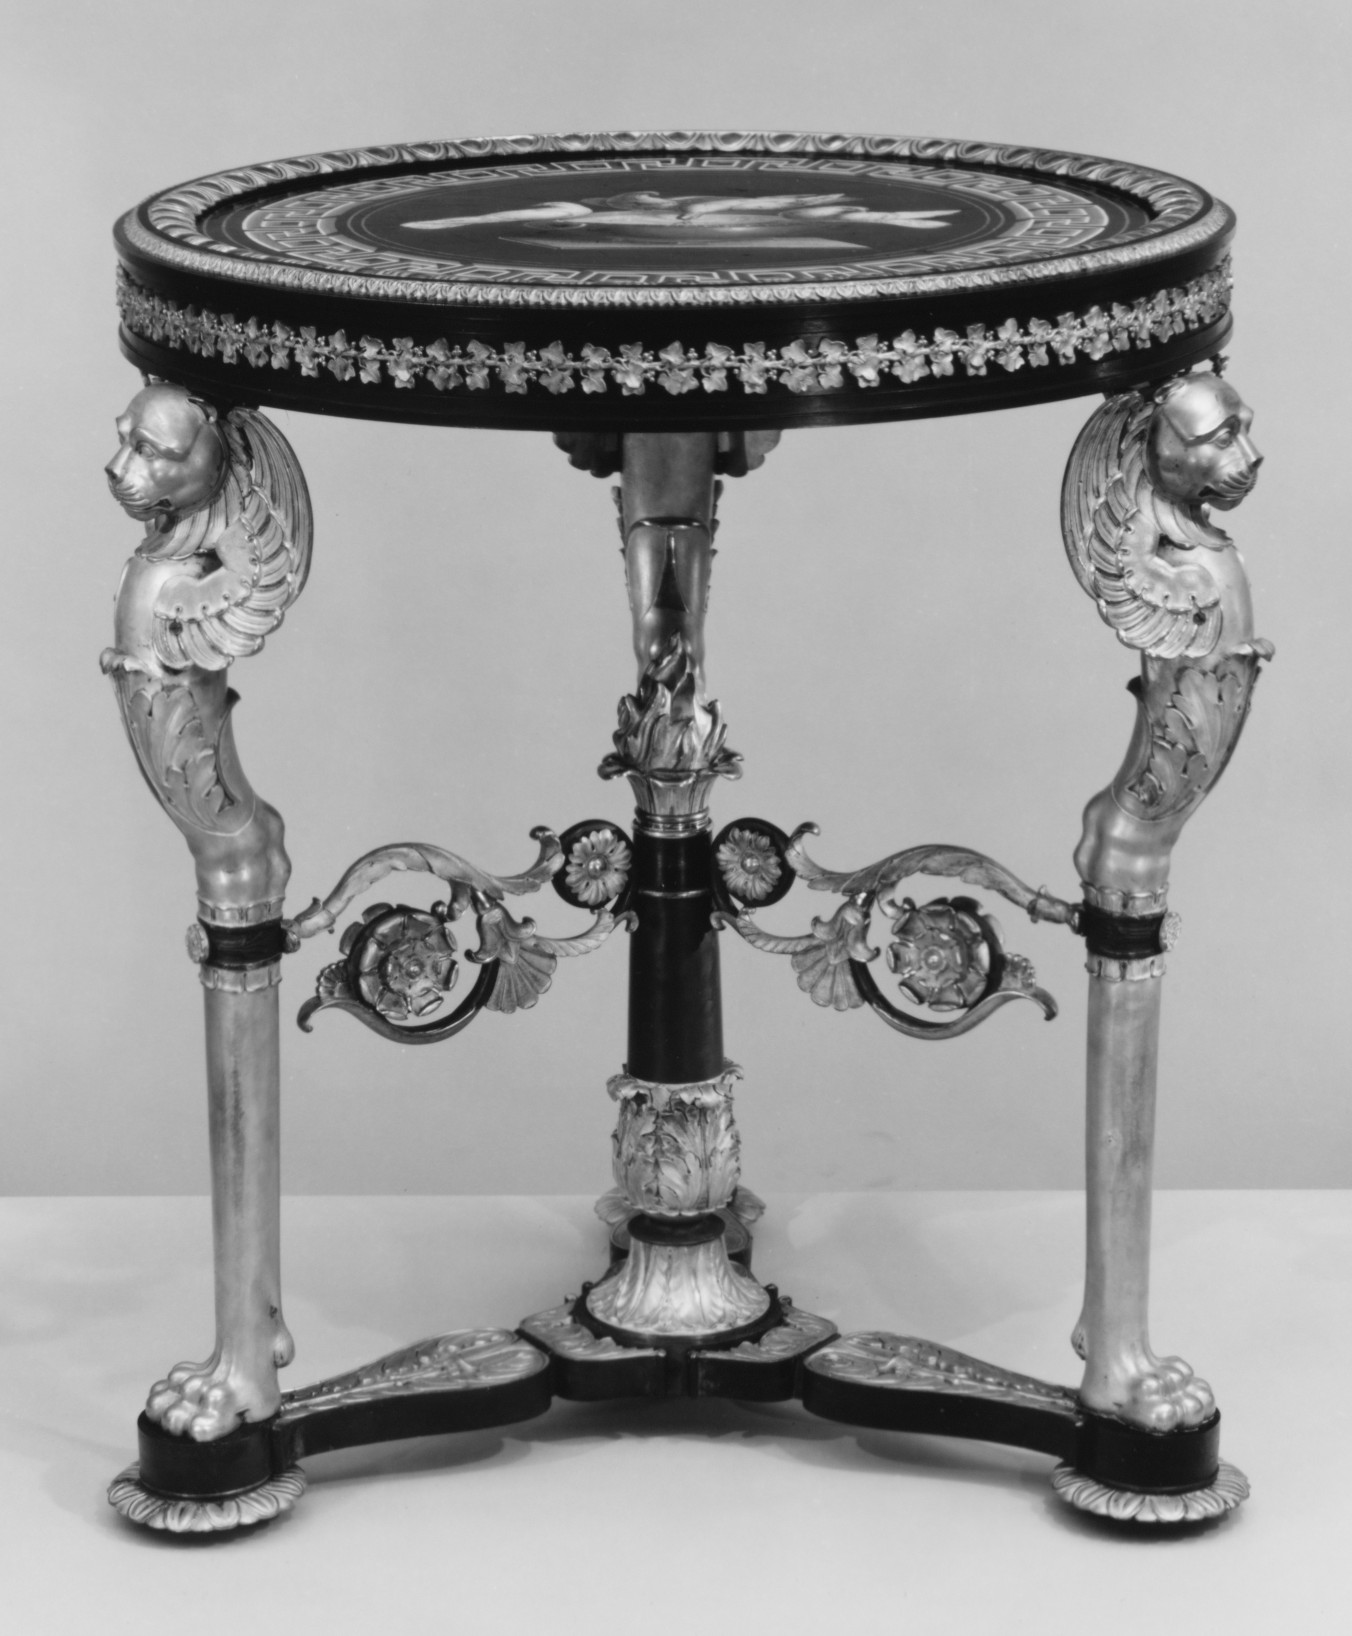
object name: tripod table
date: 1815-1825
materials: gilt bronze, wood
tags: lions